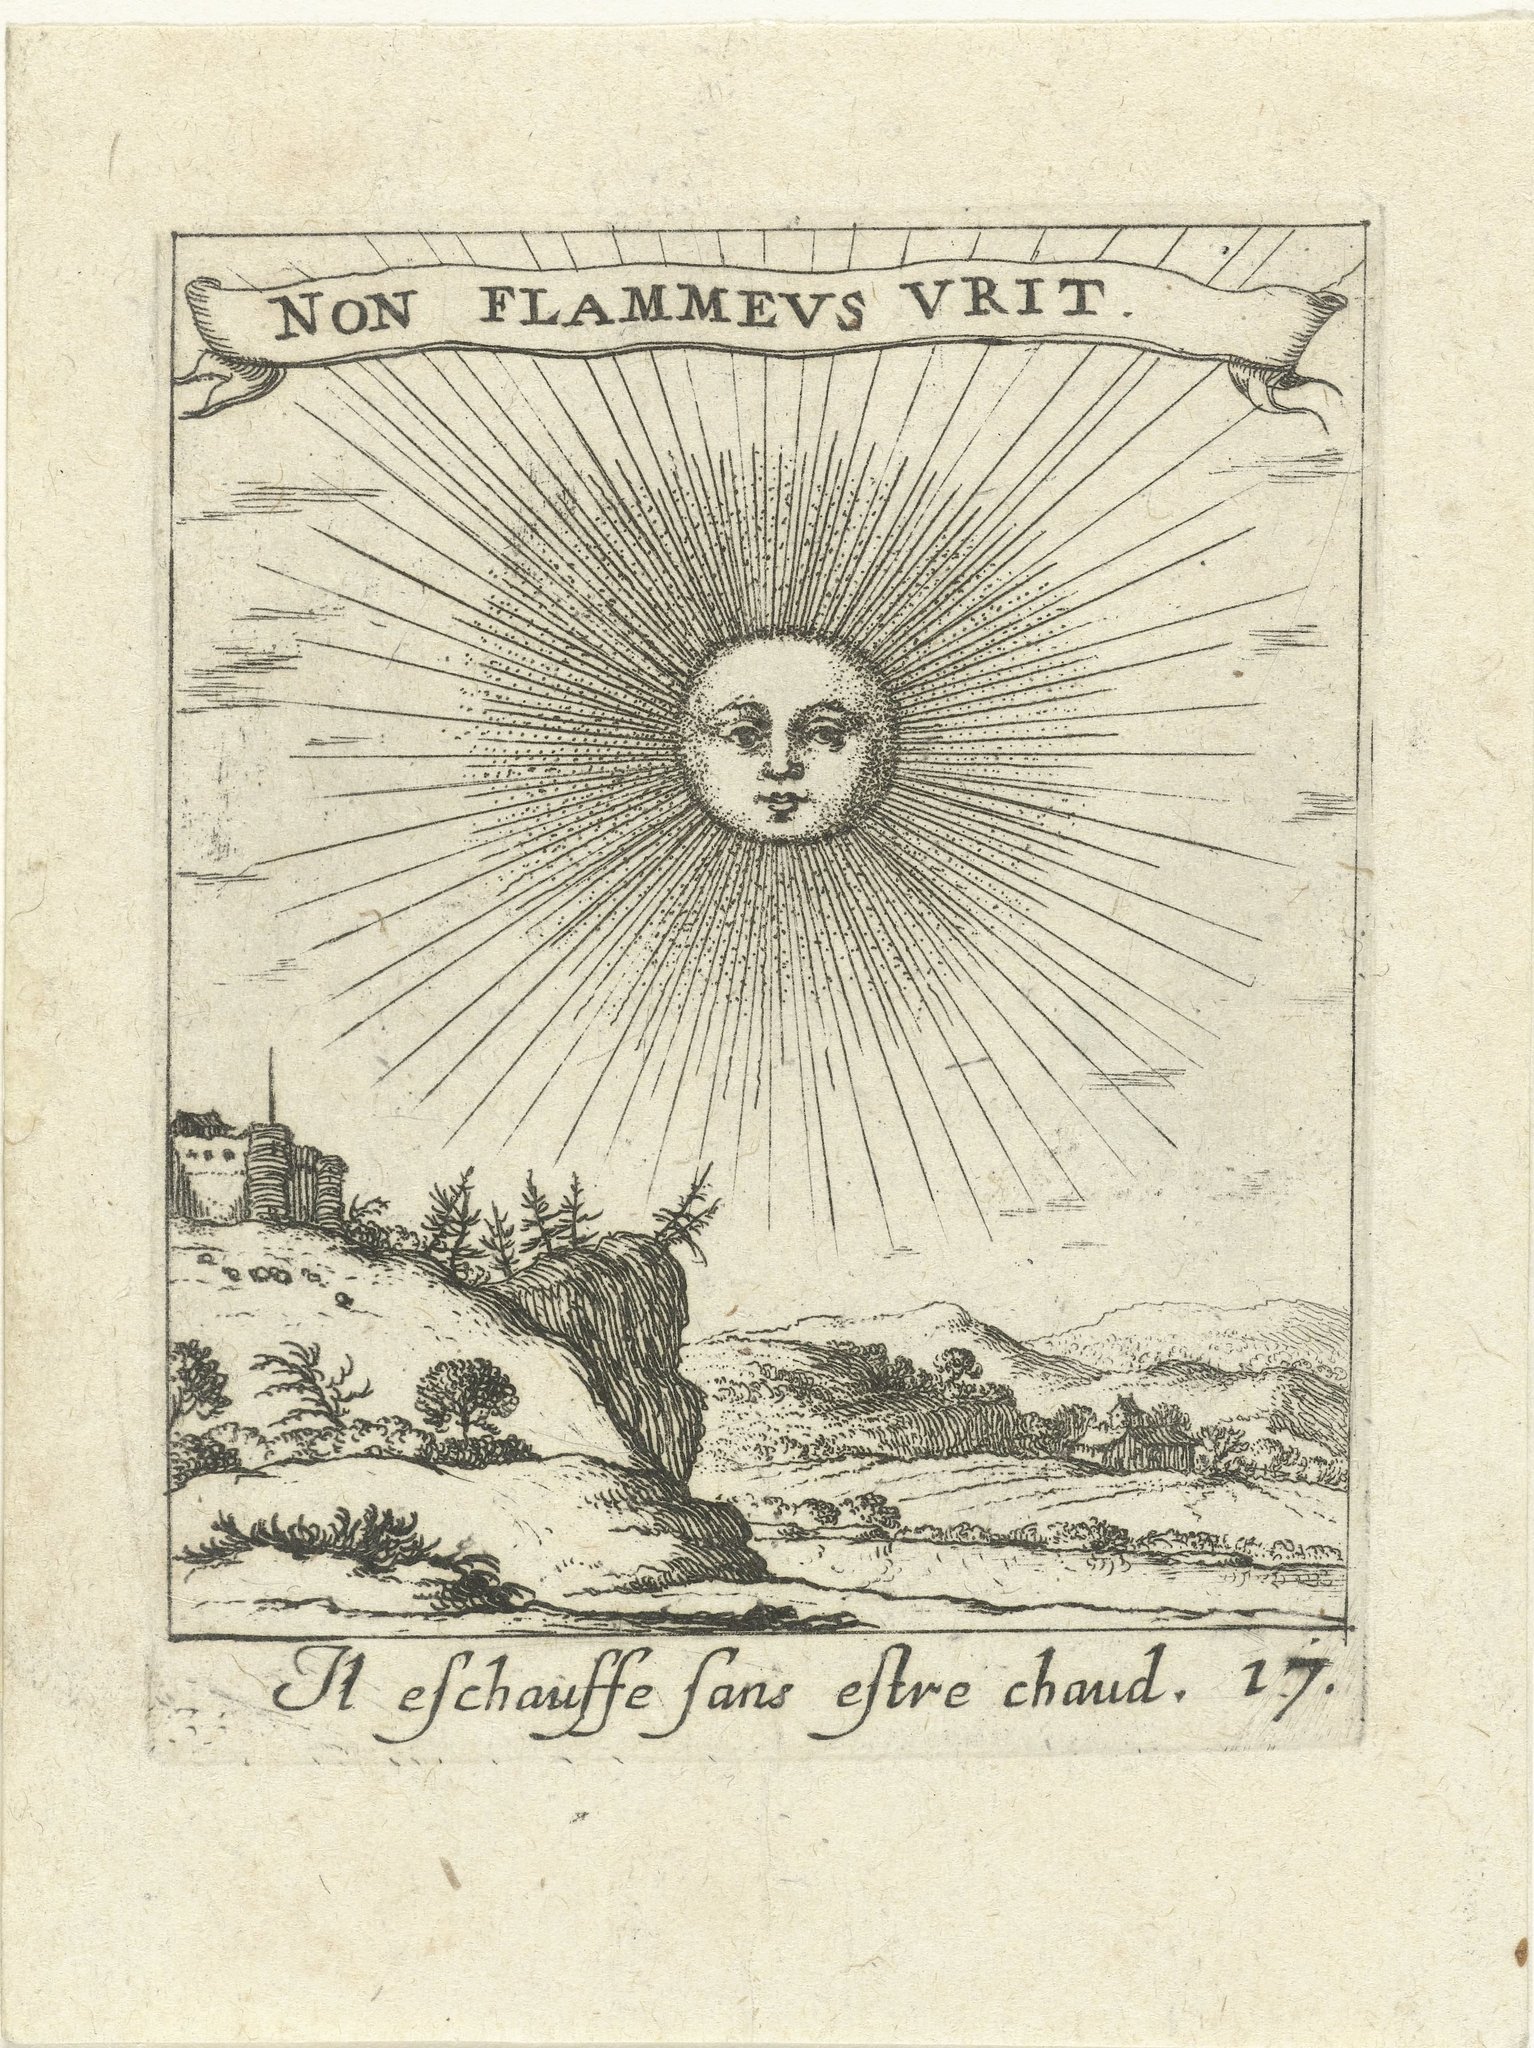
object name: print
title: Moraliserende liefdesemblemen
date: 1672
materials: paper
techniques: etching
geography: france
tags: qualities of love: first series (+ emblematical representation of concept)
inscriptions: collector's mark: Lugt 2166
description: Een stralende zon boven een berglandschap. Op een banderol een devies in Latijn en een onderschrift in Frans, beide over de liefde.